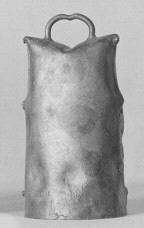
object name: cow bell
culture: german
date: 1850-1889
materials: brass, iron, leather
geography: germany